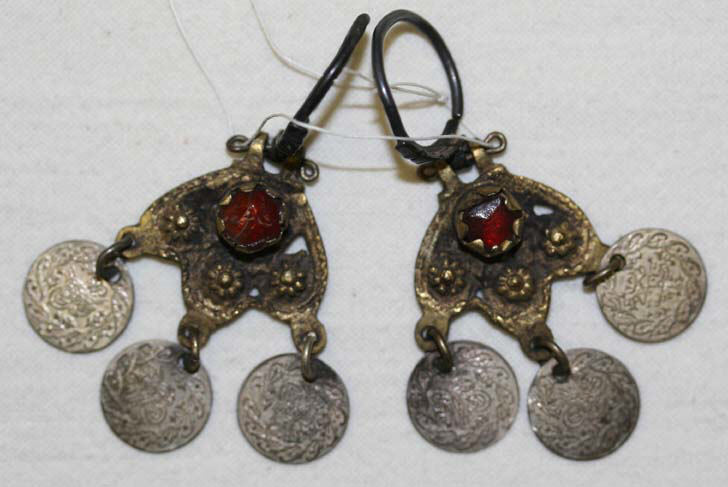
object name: earring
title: Earrings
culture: european, eastern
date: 1701-1900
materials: metal